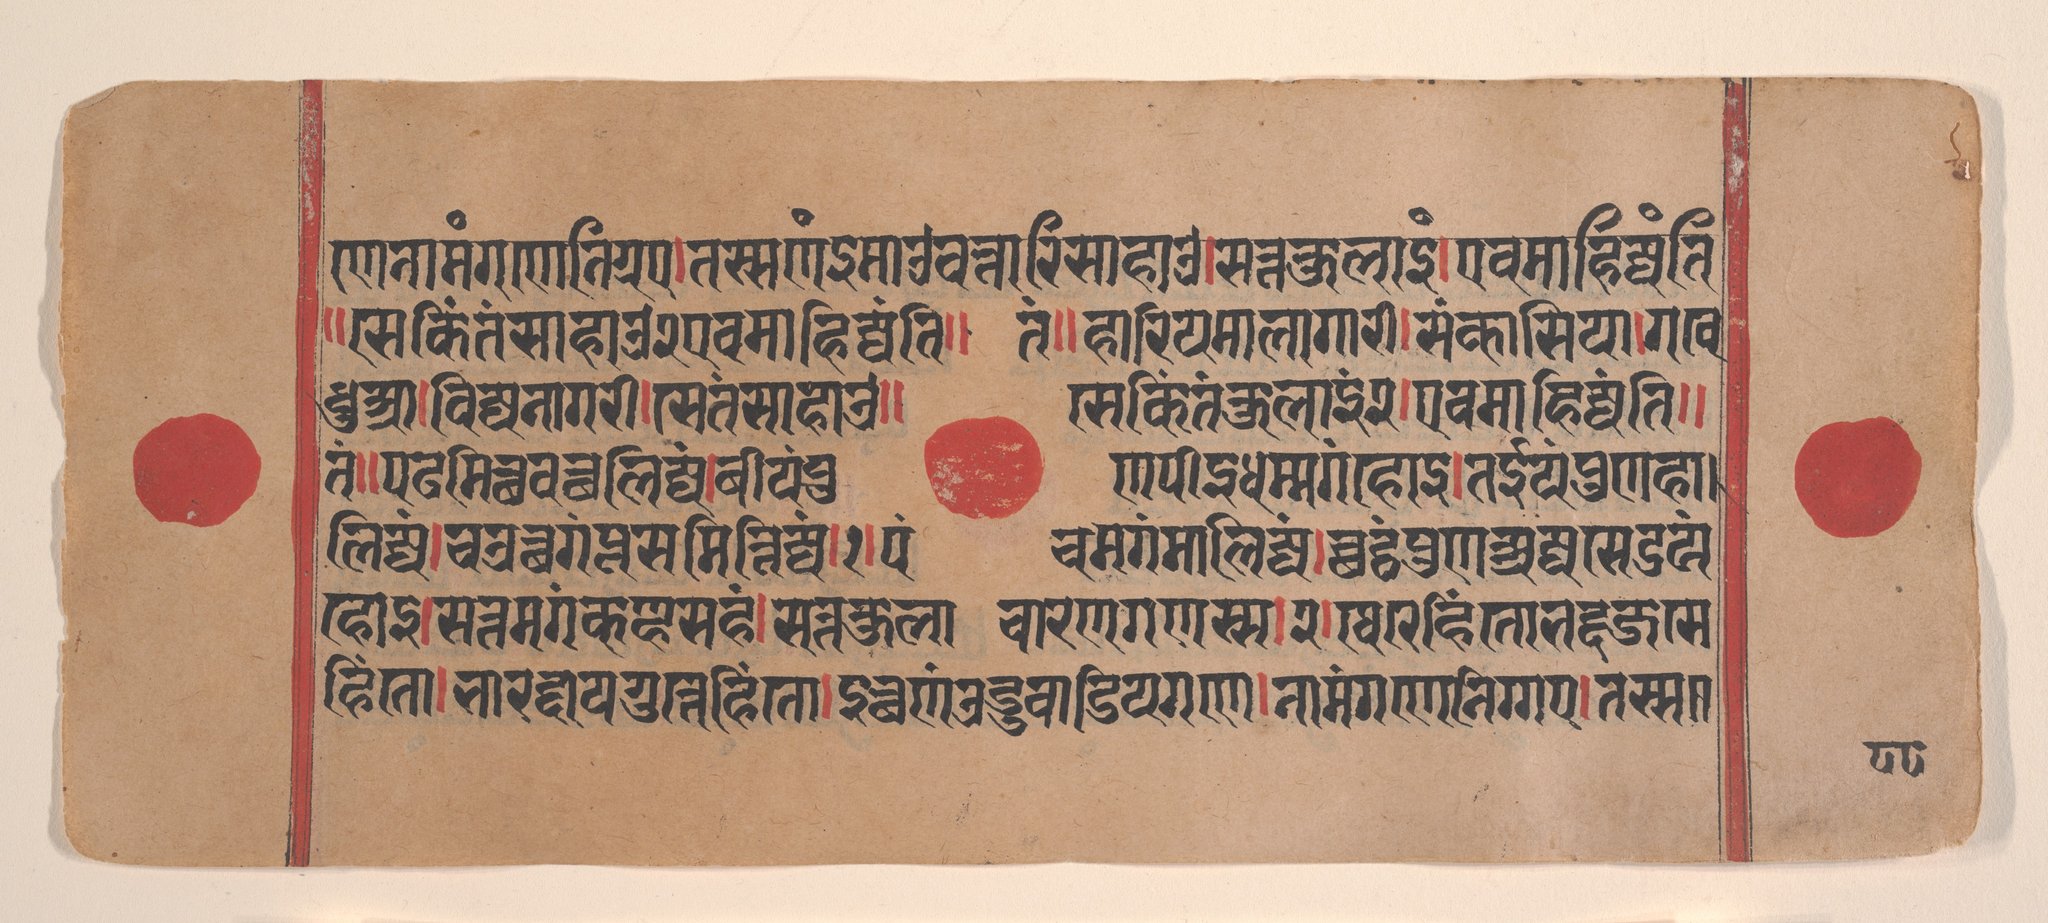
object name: folio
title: Page from a Dispersed Kalpa Sutra (Jain Book of Rituals)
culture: indian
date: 1401-1500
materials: gold, ink, paper, watercolor